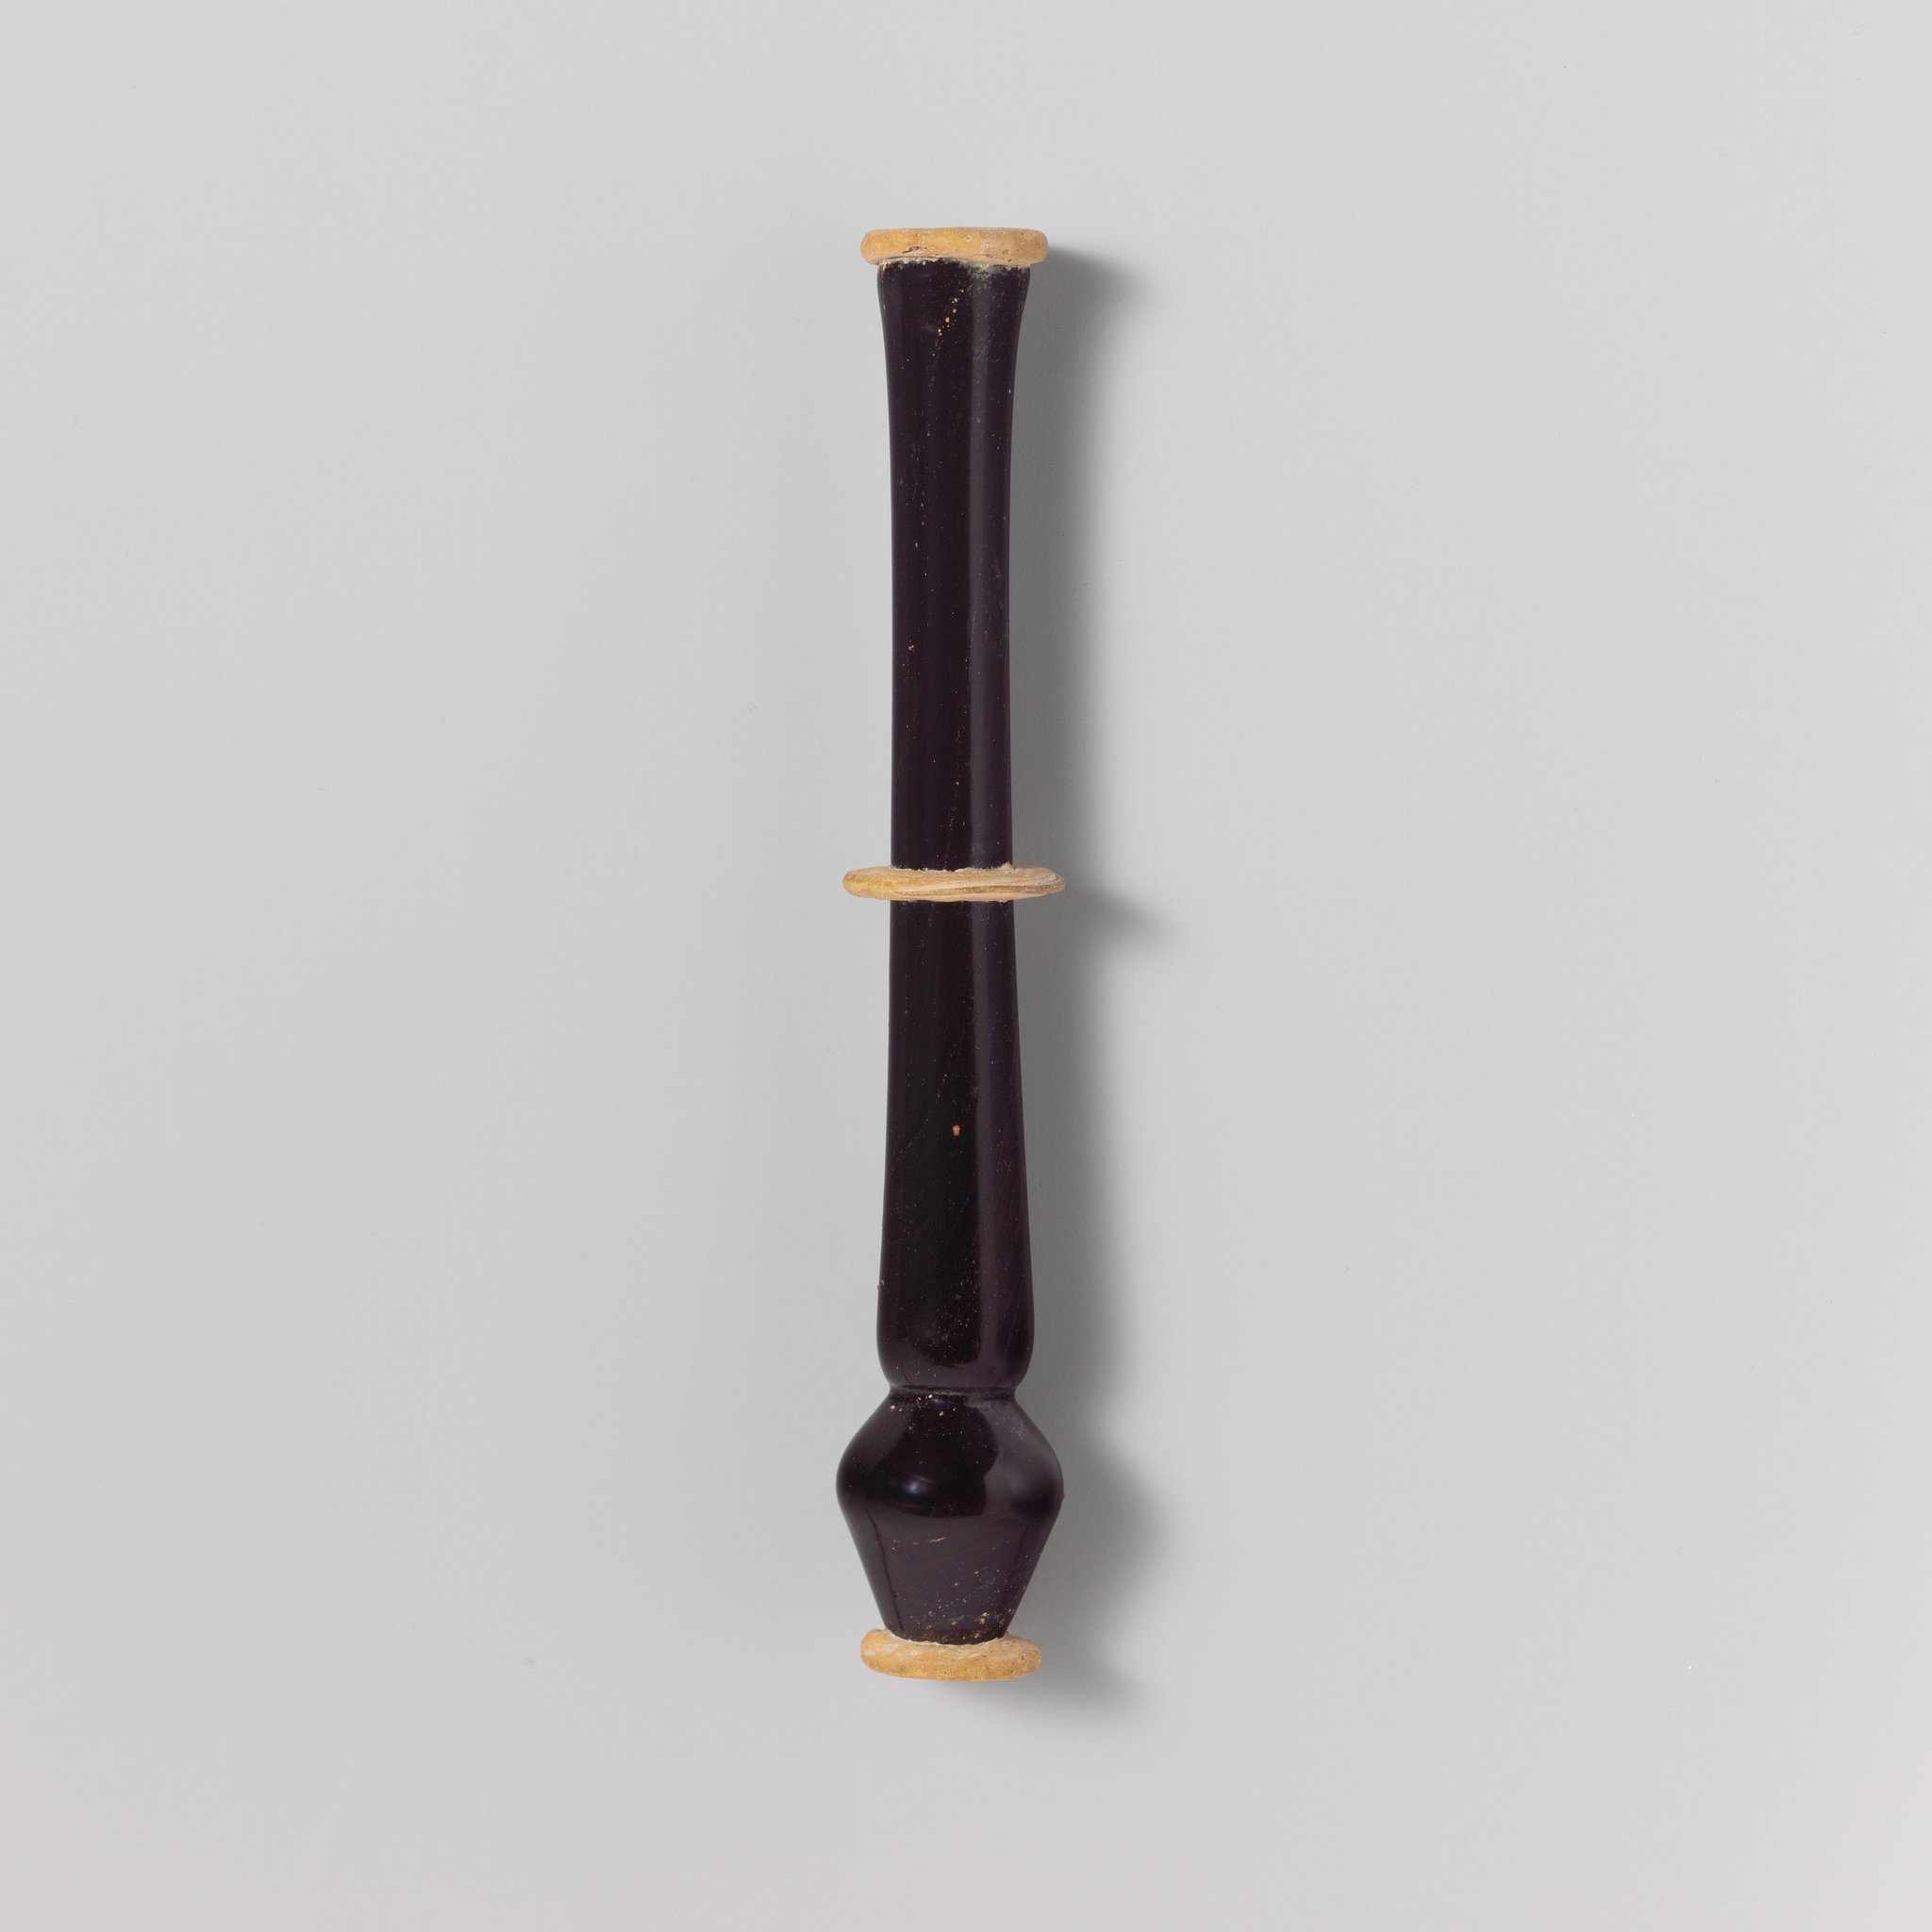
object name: bottle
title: Glass bottle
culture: roman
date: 301-400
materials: glass